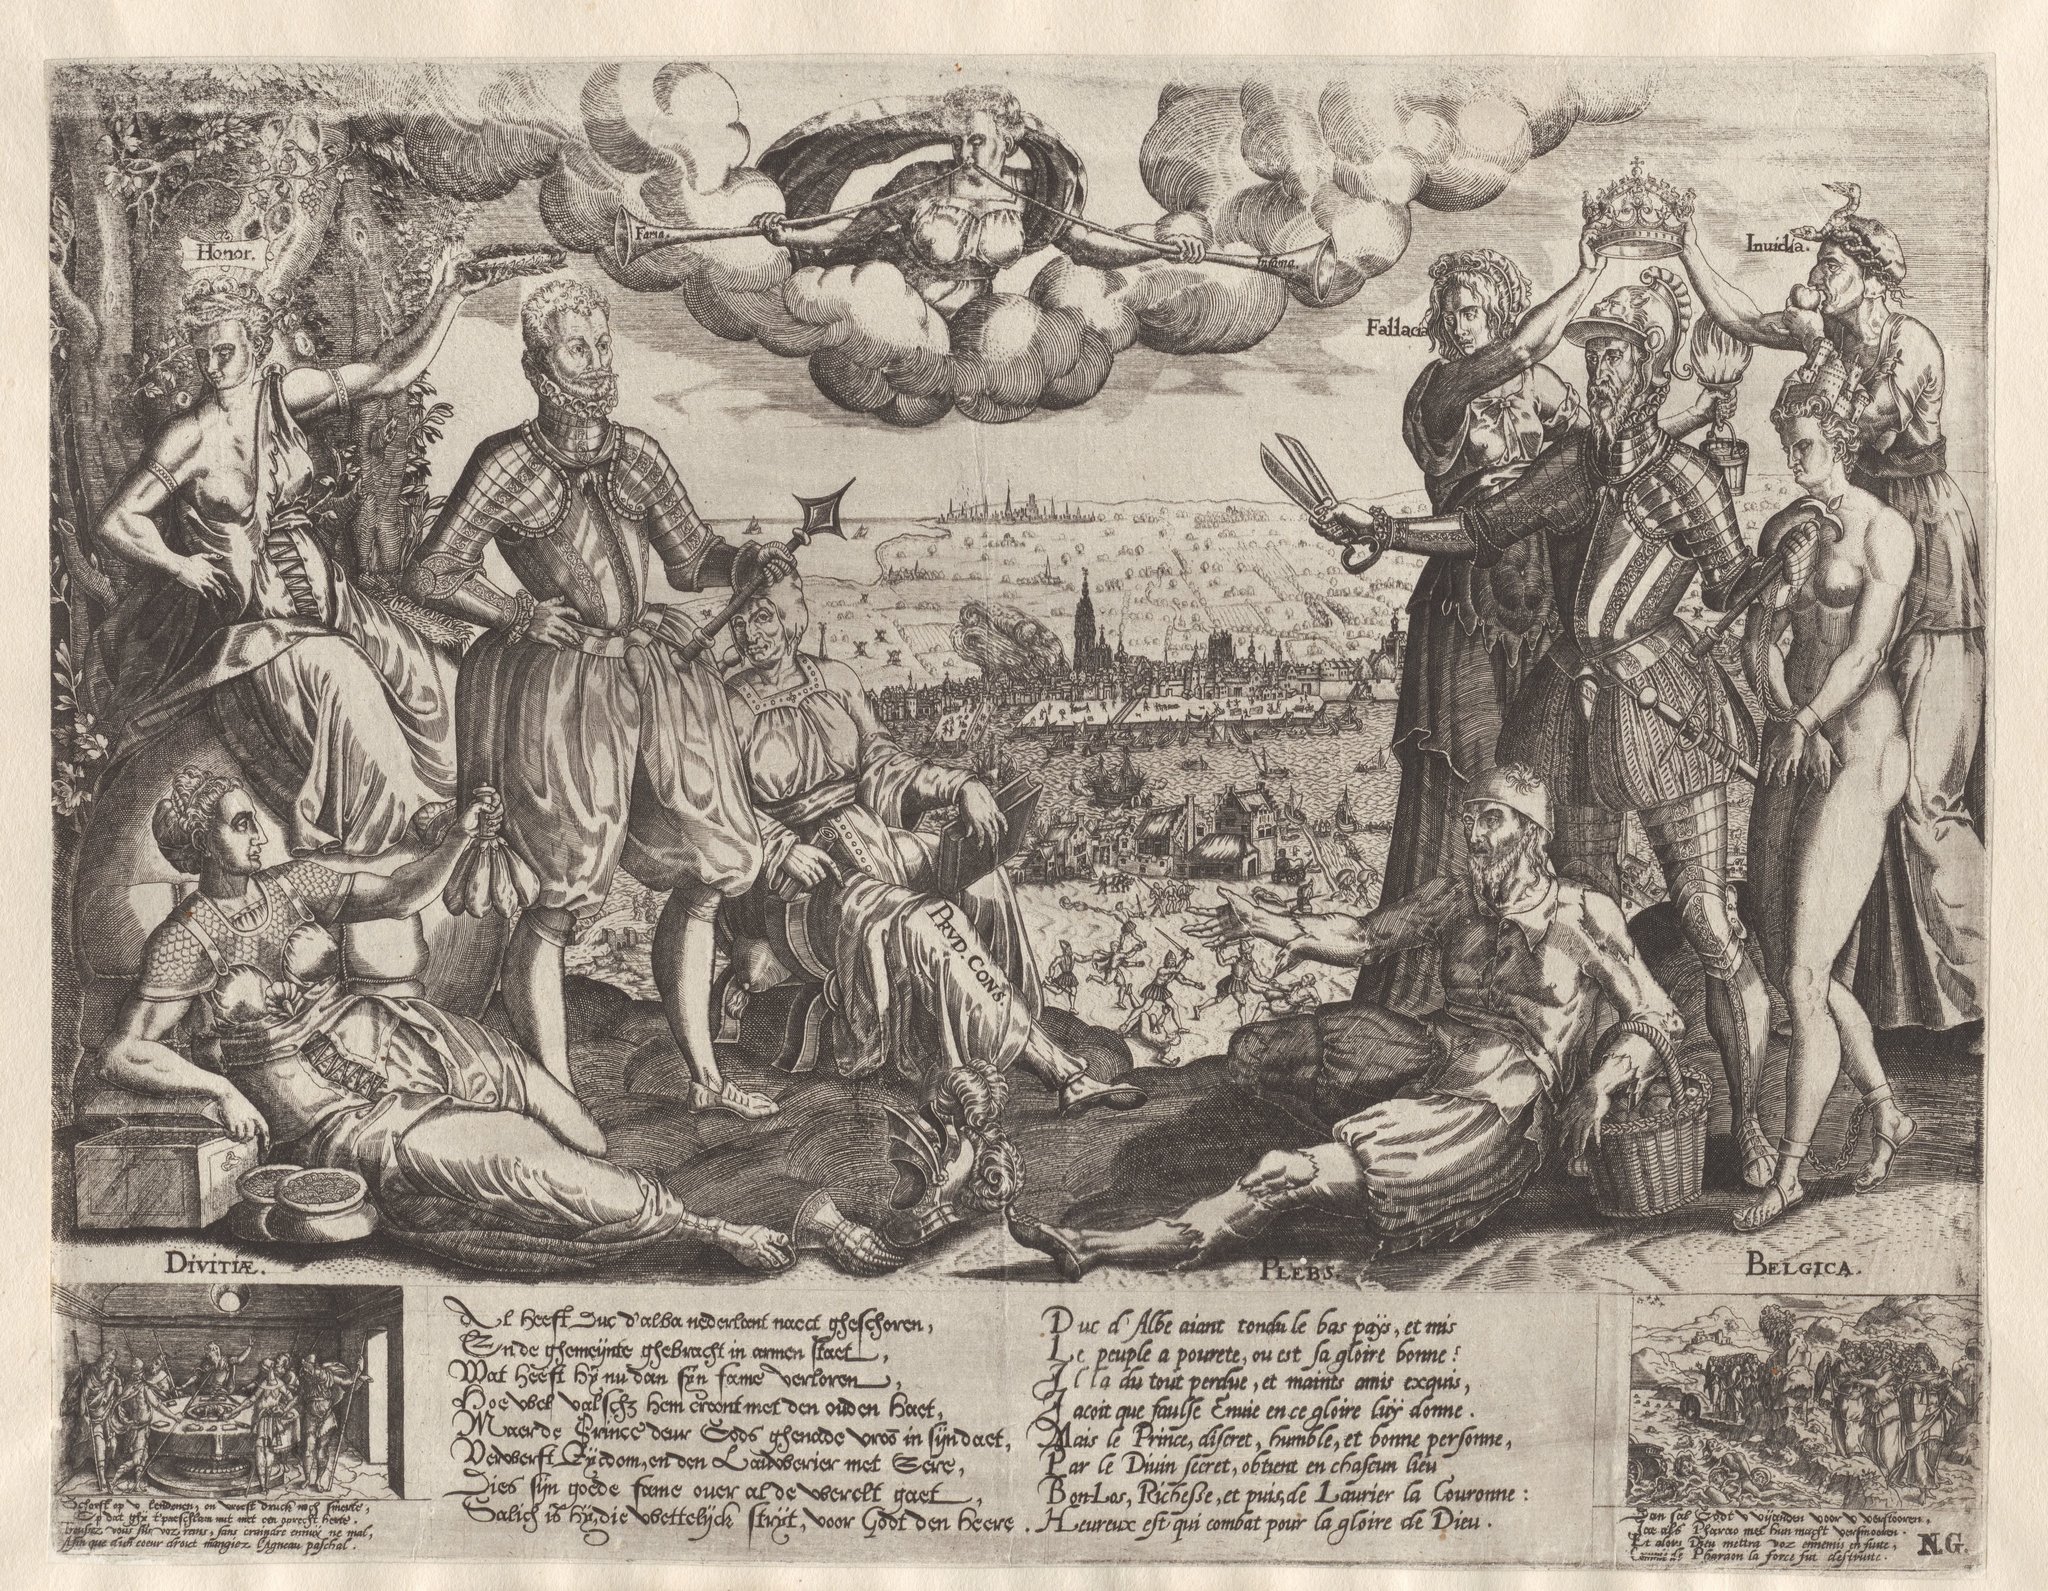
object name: print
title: Vergelijking tussen Oranje en Alva, met op de achtergrond de Spaanse Furie, ca. 1577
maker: theodor de bry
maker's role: draughtsman, print maker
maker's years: 1528-1598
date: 1576-1577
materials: paper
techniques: engraving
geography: low countries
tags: delft, william i (prince of orange), fernando álvarez de toledo (3rd duke of alba), counsel; 'consiglio' (ripa), envy; 'invidia' (ripa) ~ personification of one of the seven deadly sins, the israelites prepare to leave: the people fill their troughs with unleavened dough, wrap them in clothing and carry them on their shoulders, with his people safe on the shore, moses raises his hands and causes the water to return; pharaoh's army perishes in the water (red sea), wealth, opulence; 'opulenza', 'richezza' (ripa), fame; 'fama', 'fama buona', 'fama chiara' (ripa), honour, glory; 'ampiezza della gloria', 'gloria', 'gloria de prencipi', 'gloria & honore', 'honore', 'sublimatà della gloria' (ripa), the poor, falsehood, antwerp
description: Allegorische vergelijking tussen Oranje en Alva, met op de achtergrond de Spaanse Furie. Links Willem van Oranje begeleid door de personificaties Eer (Honor), Rijkdom (Divitiae) en Wijze Raad (Prud. Cons.). Rechts Alva tussen Valsheid (Fallacia) en Afgunst (Invidia). Hij voert de Nederlandse Maagd (Belgica) naakt en geboeid aan de arm. Aan zijn voeten het Volk (Plebs) als een arme bedelaar. Op de achtergrond de Spaanse Furie te Antwerpen. Onderaan twee verzen van elk 8 regels in het Nederlands en Frans met aan weerszijden twee kleine scènes uit de uittocht van de Israëlieten uit Egypte, de viering van het Pascha (links) en de doortocht door de Rode Zee. In de lucht Roem (Fama) met bazuinen.